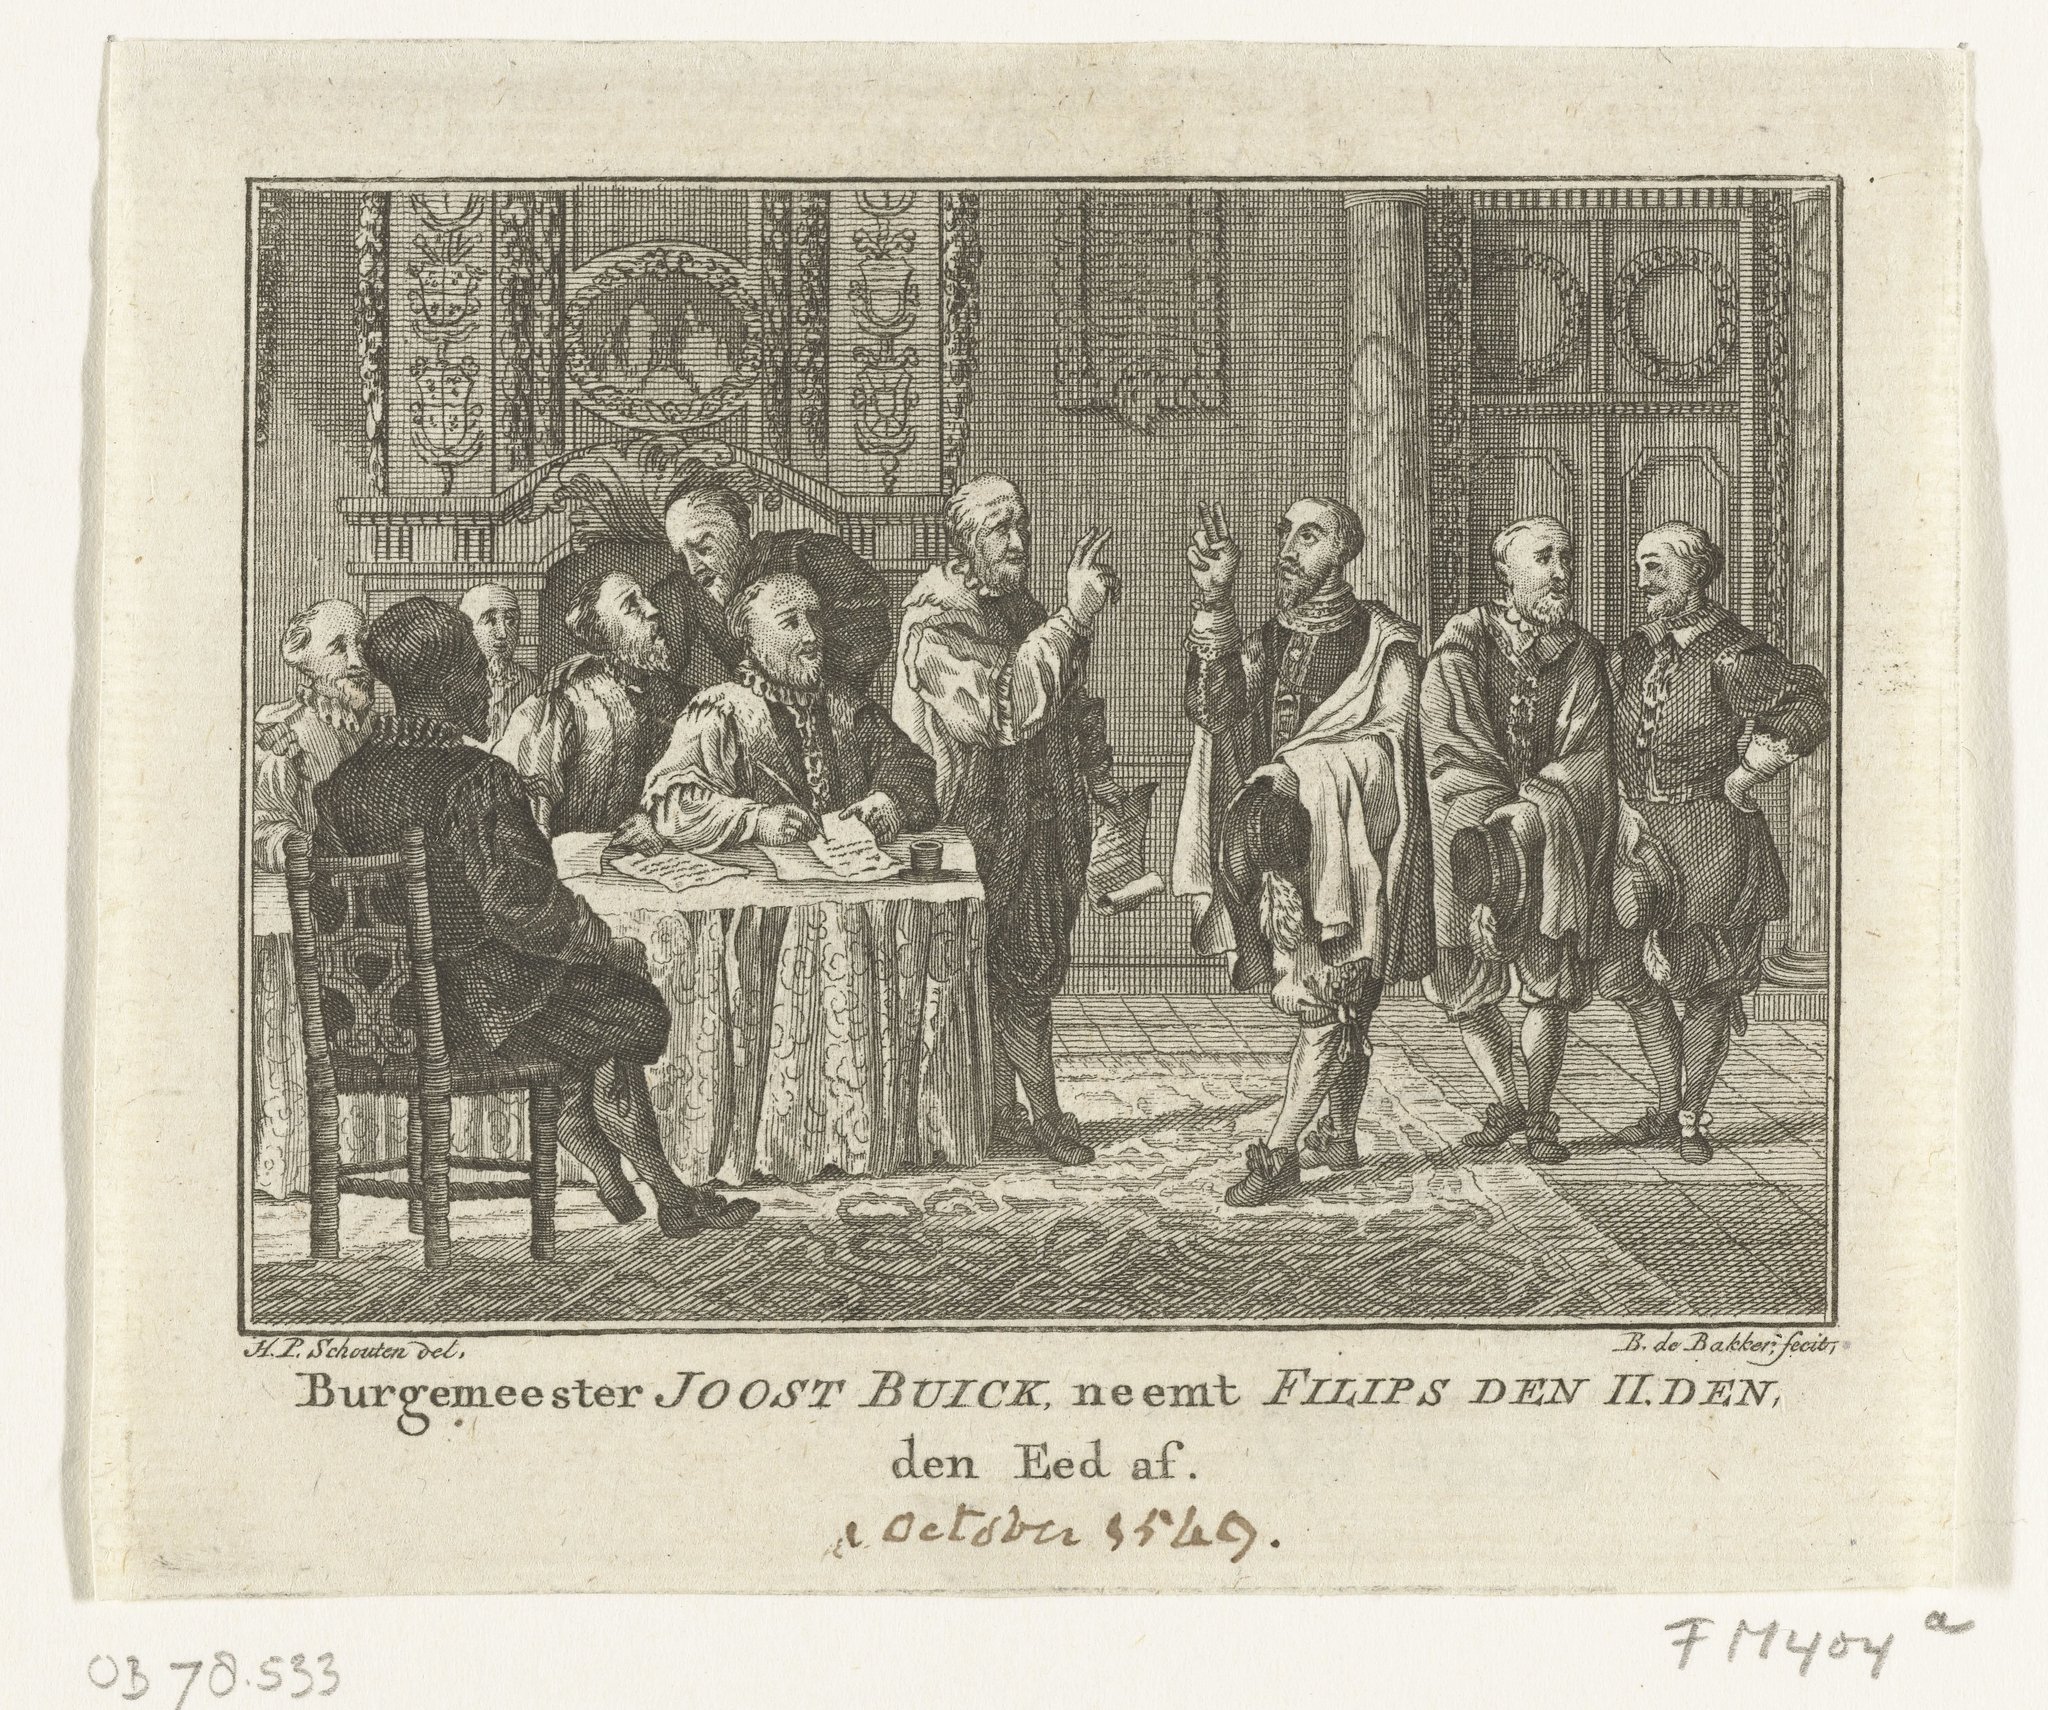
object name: print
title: Burgemeester Joost Buyck van Amsterdam neemt Filips II de eed af, 1549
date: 1780-1782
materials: paper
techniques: etching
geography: northern netherlands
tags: philip ii of spain, leiden, mayor, swearing an oath (with two fingers raised), amsterdam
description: Burgemeester Joost Buyck van Amsterdam neemt Filips II de eed af als graaf van Holland, 1549. Interieur met de koning staande voor een tafel waarachter de burgemeester is gezeten.